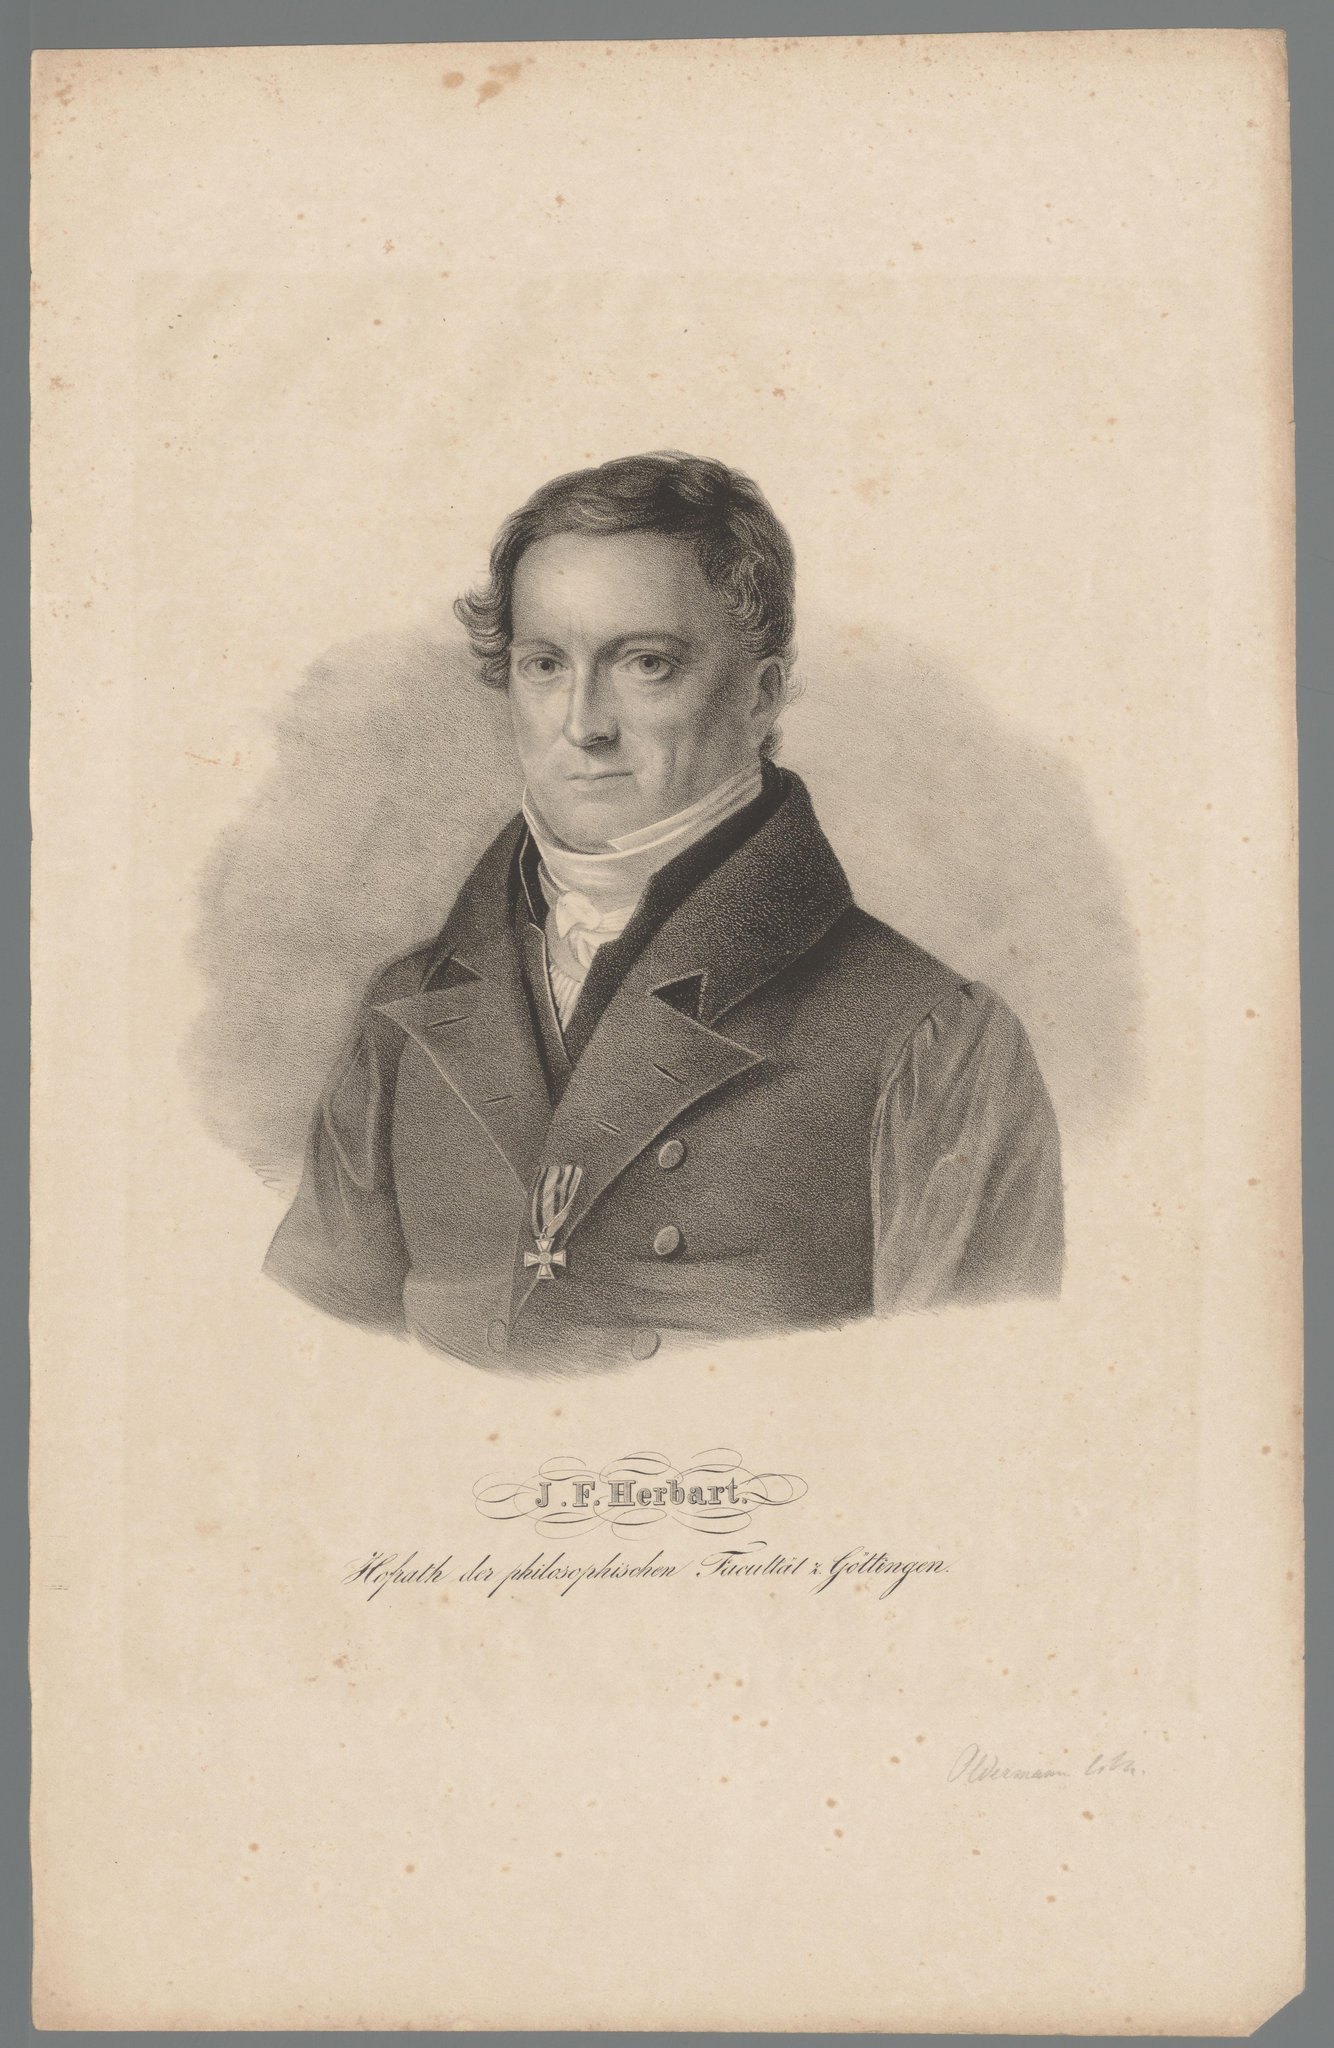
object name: print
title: Portret van Johann Friedrich Herbart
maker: ernst friedrich oldermann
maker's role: print maker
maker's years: 1802-1874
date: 1812-1874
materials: paper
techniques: lithograph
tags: adult man, historical persons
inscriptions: collector's mark: Lugt 2228